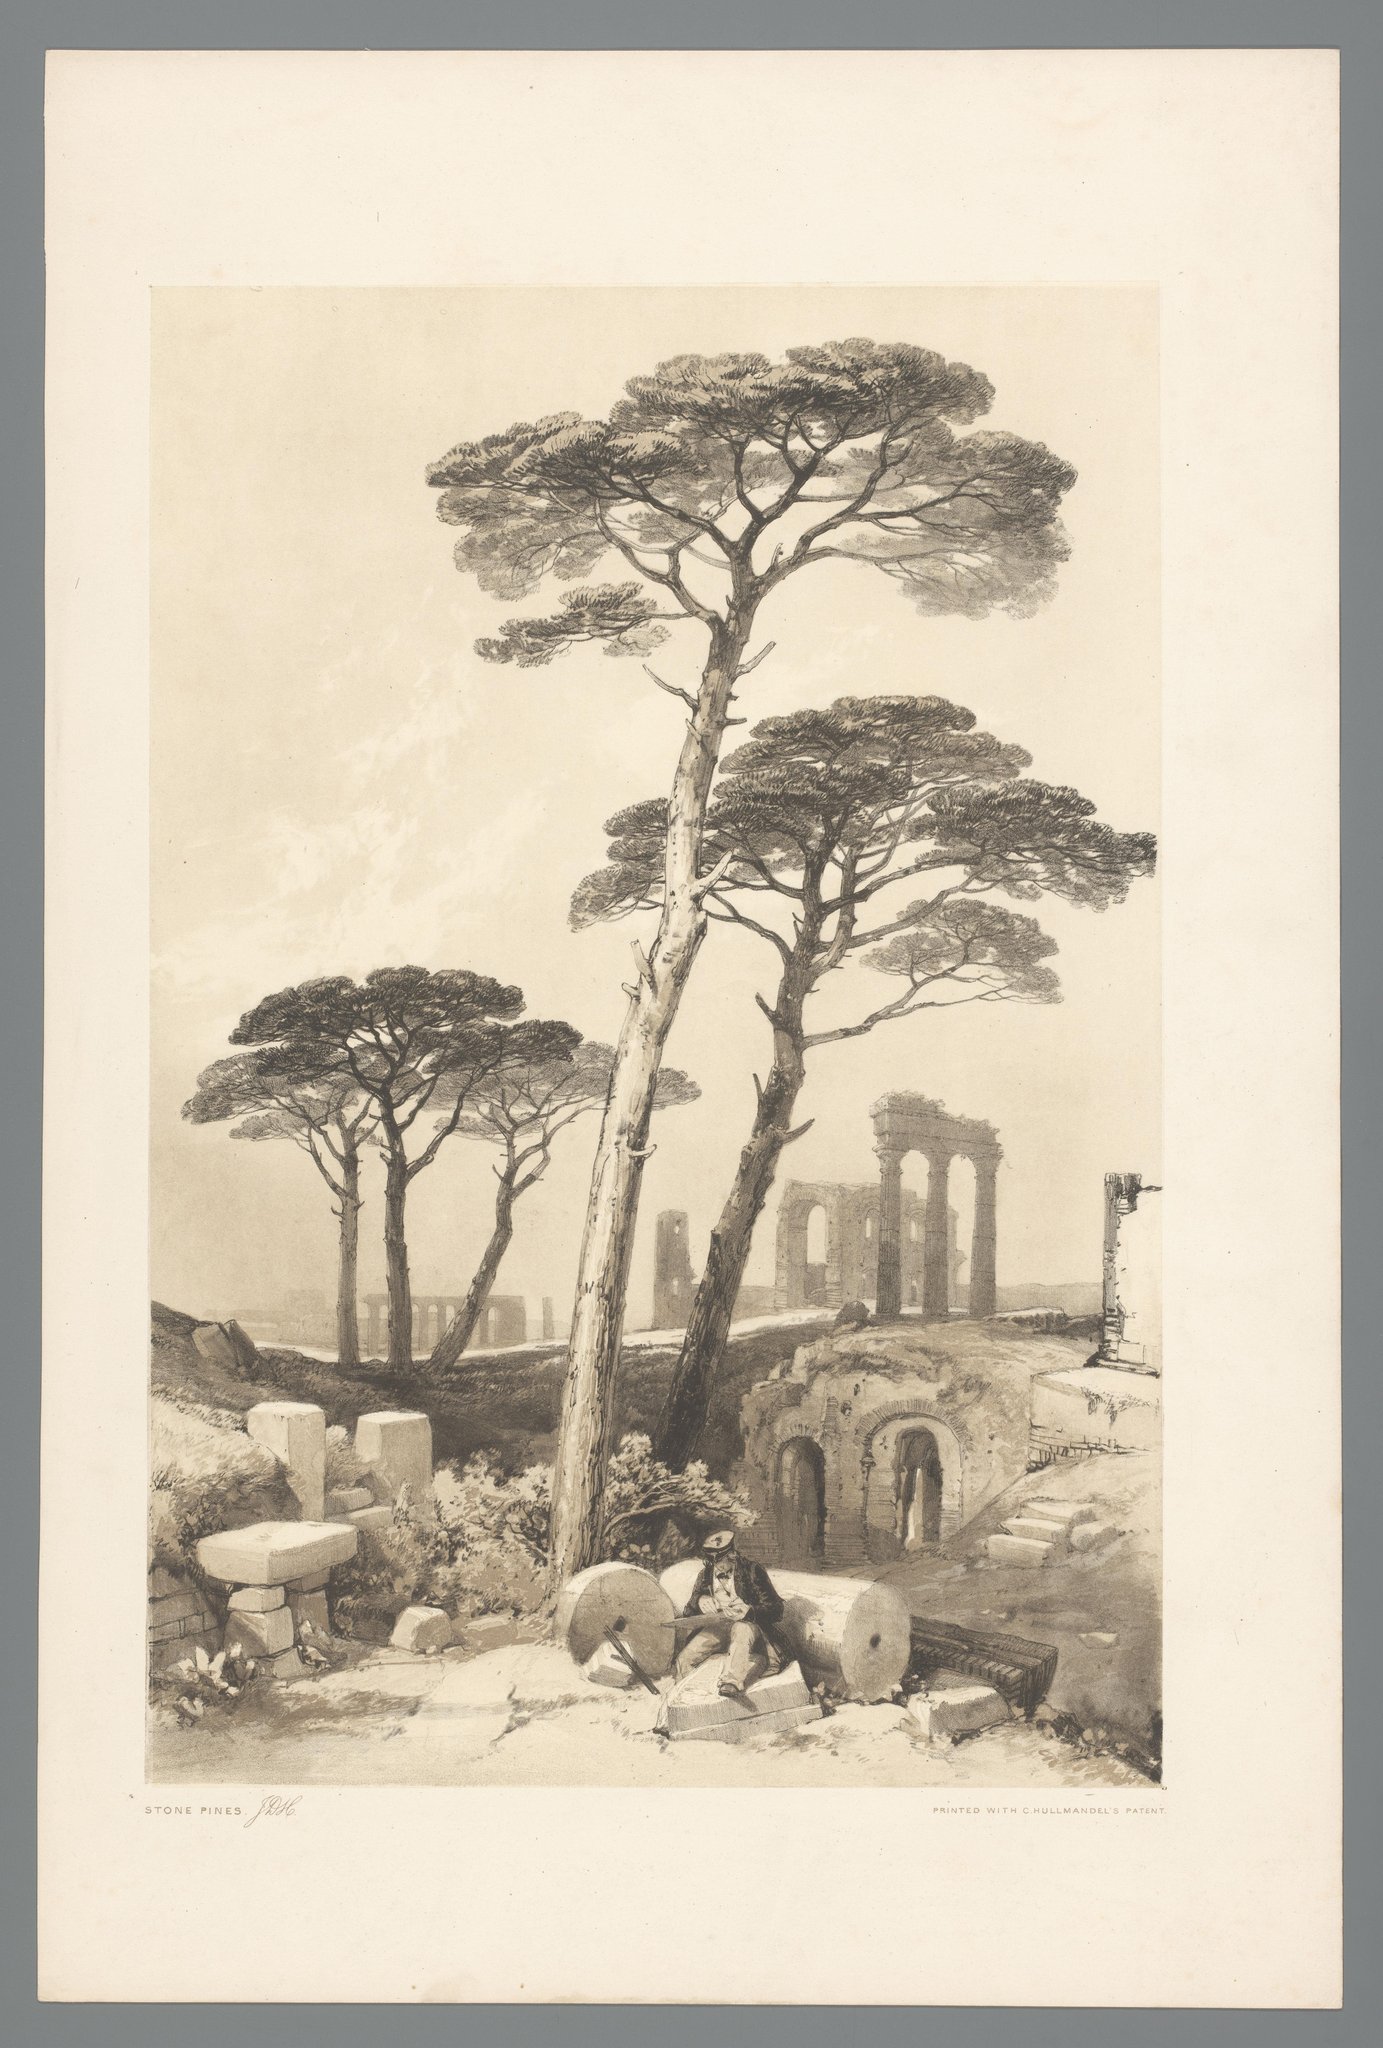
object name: print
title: Park en bos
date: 1841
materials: paper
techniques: tone lithography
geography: london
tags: park, forest, wood, landscape with ruins (+ city(-scape) with figures, staffage), trees: pine, rome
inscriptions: collector's mark: Lugt 2760, collector's mark: Lugt 2228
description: Prent maakt deel uit van een serie van 24 prenten.